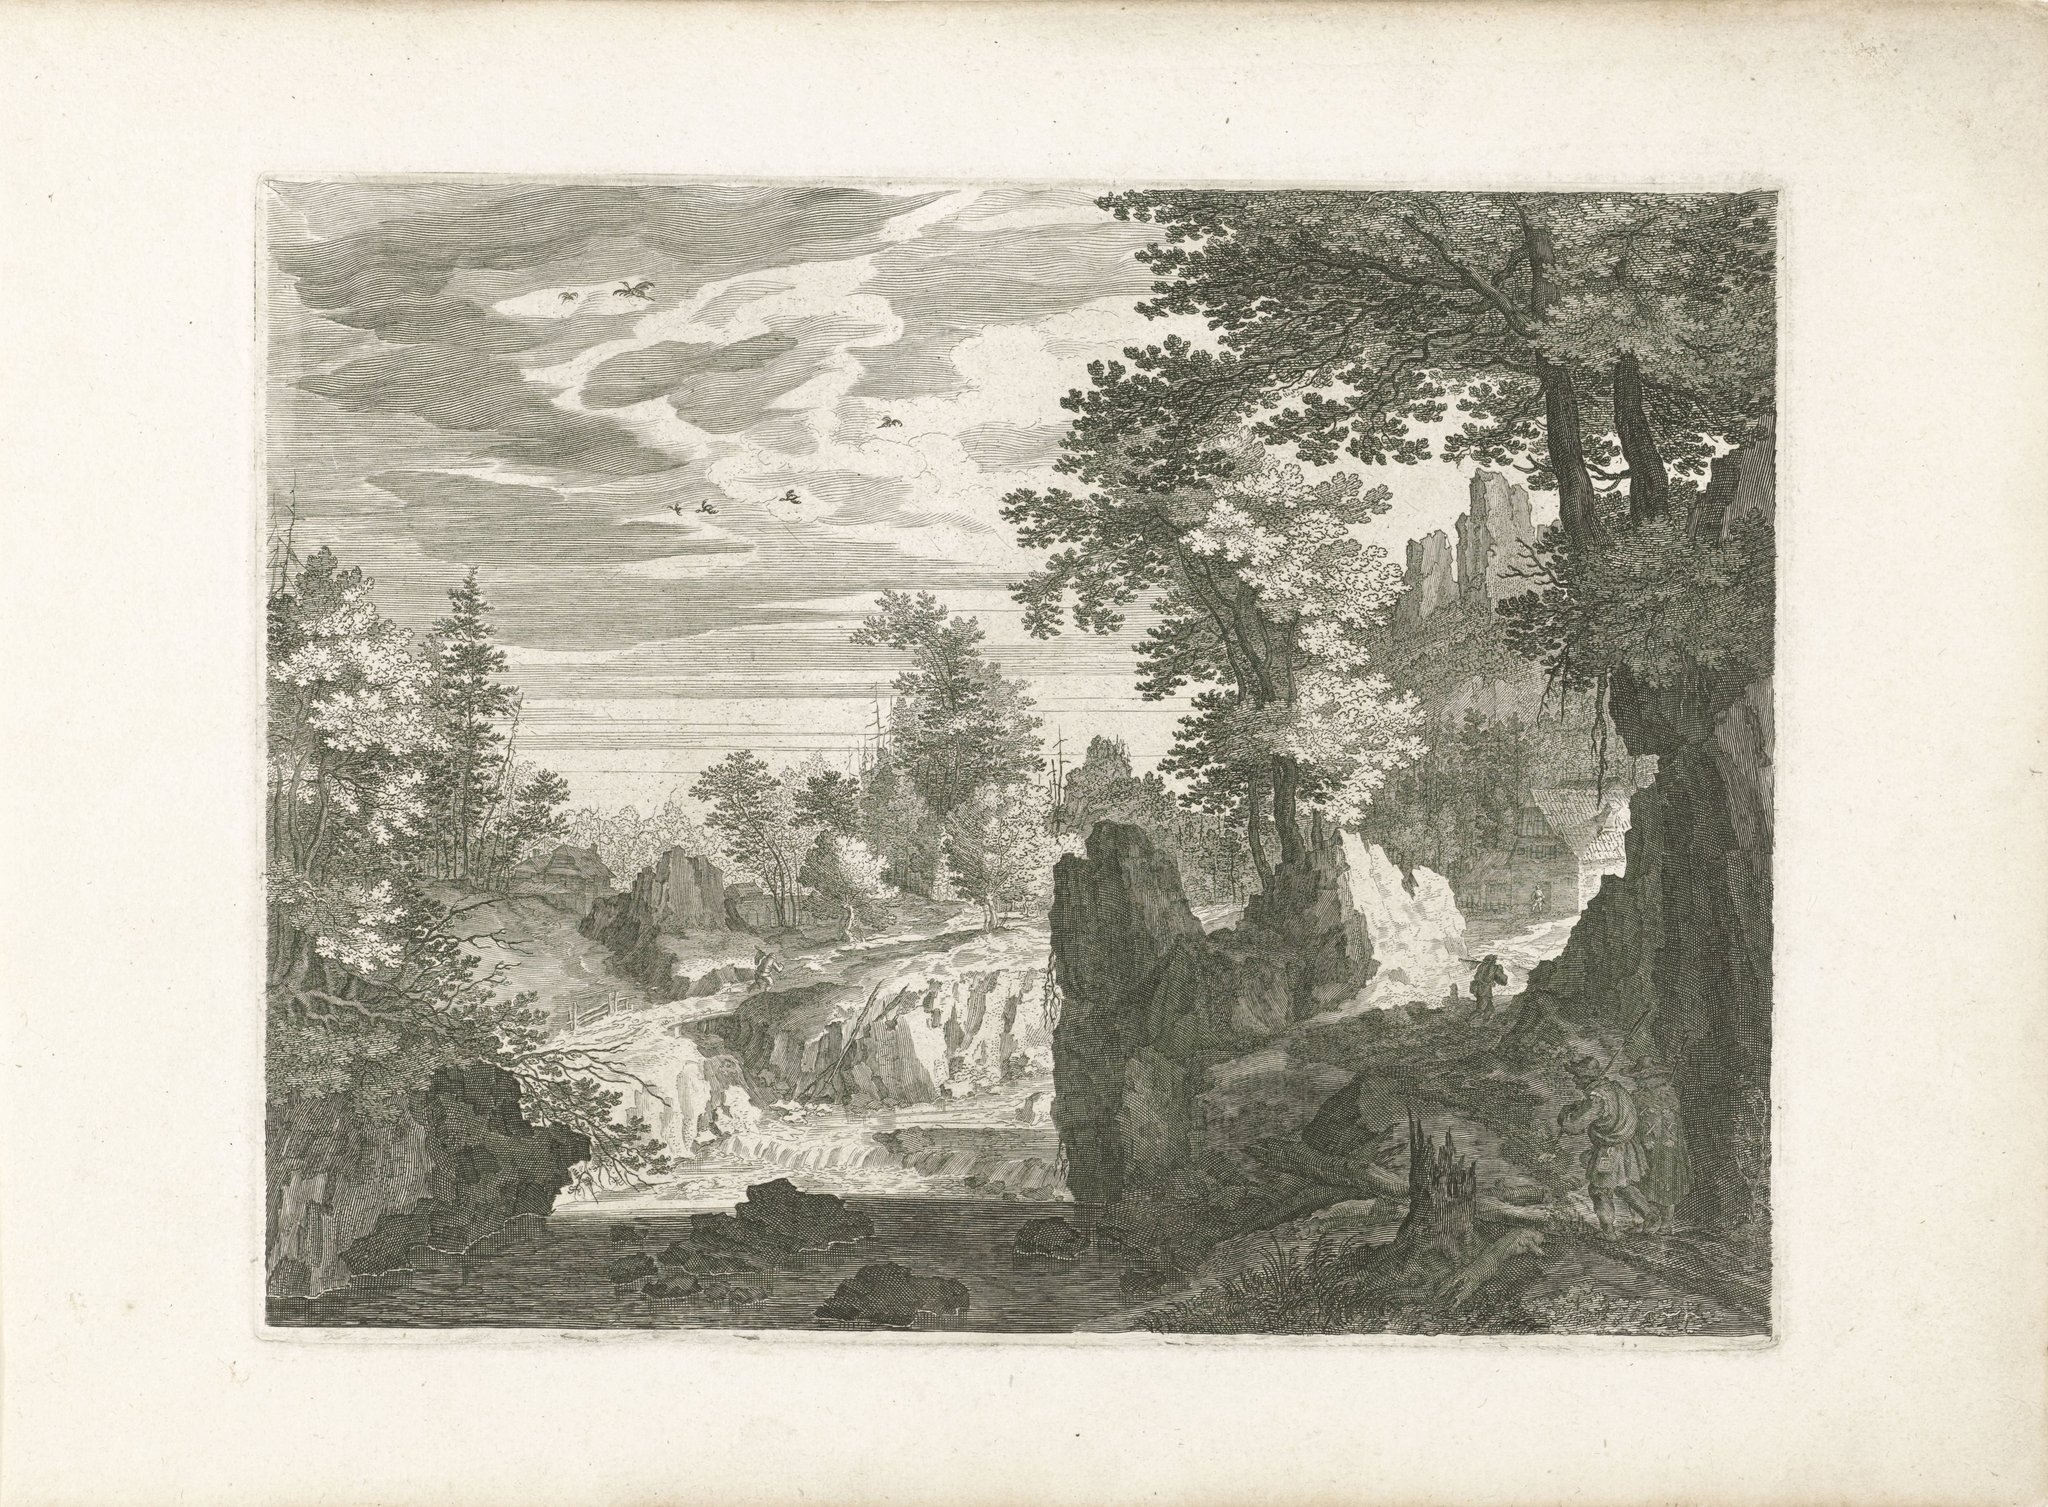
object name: print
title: Weg langs een rivier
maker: aegidius sadeler (ii)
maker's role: draughtsman, print maker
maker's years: 1568-1629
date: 1597-1629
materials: paper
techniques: engraving, etching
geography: prague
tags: 'en route', traveller under way, waterfall (+ landscape with figures, staffage)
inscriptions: collector's mark: Lugt 2228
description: Drie mannen lopend op een landweg langs een rivier. Rechts, achter de bomen, een huis. De tweede prent van een vierdelige reeks met landschappen in Bohemen